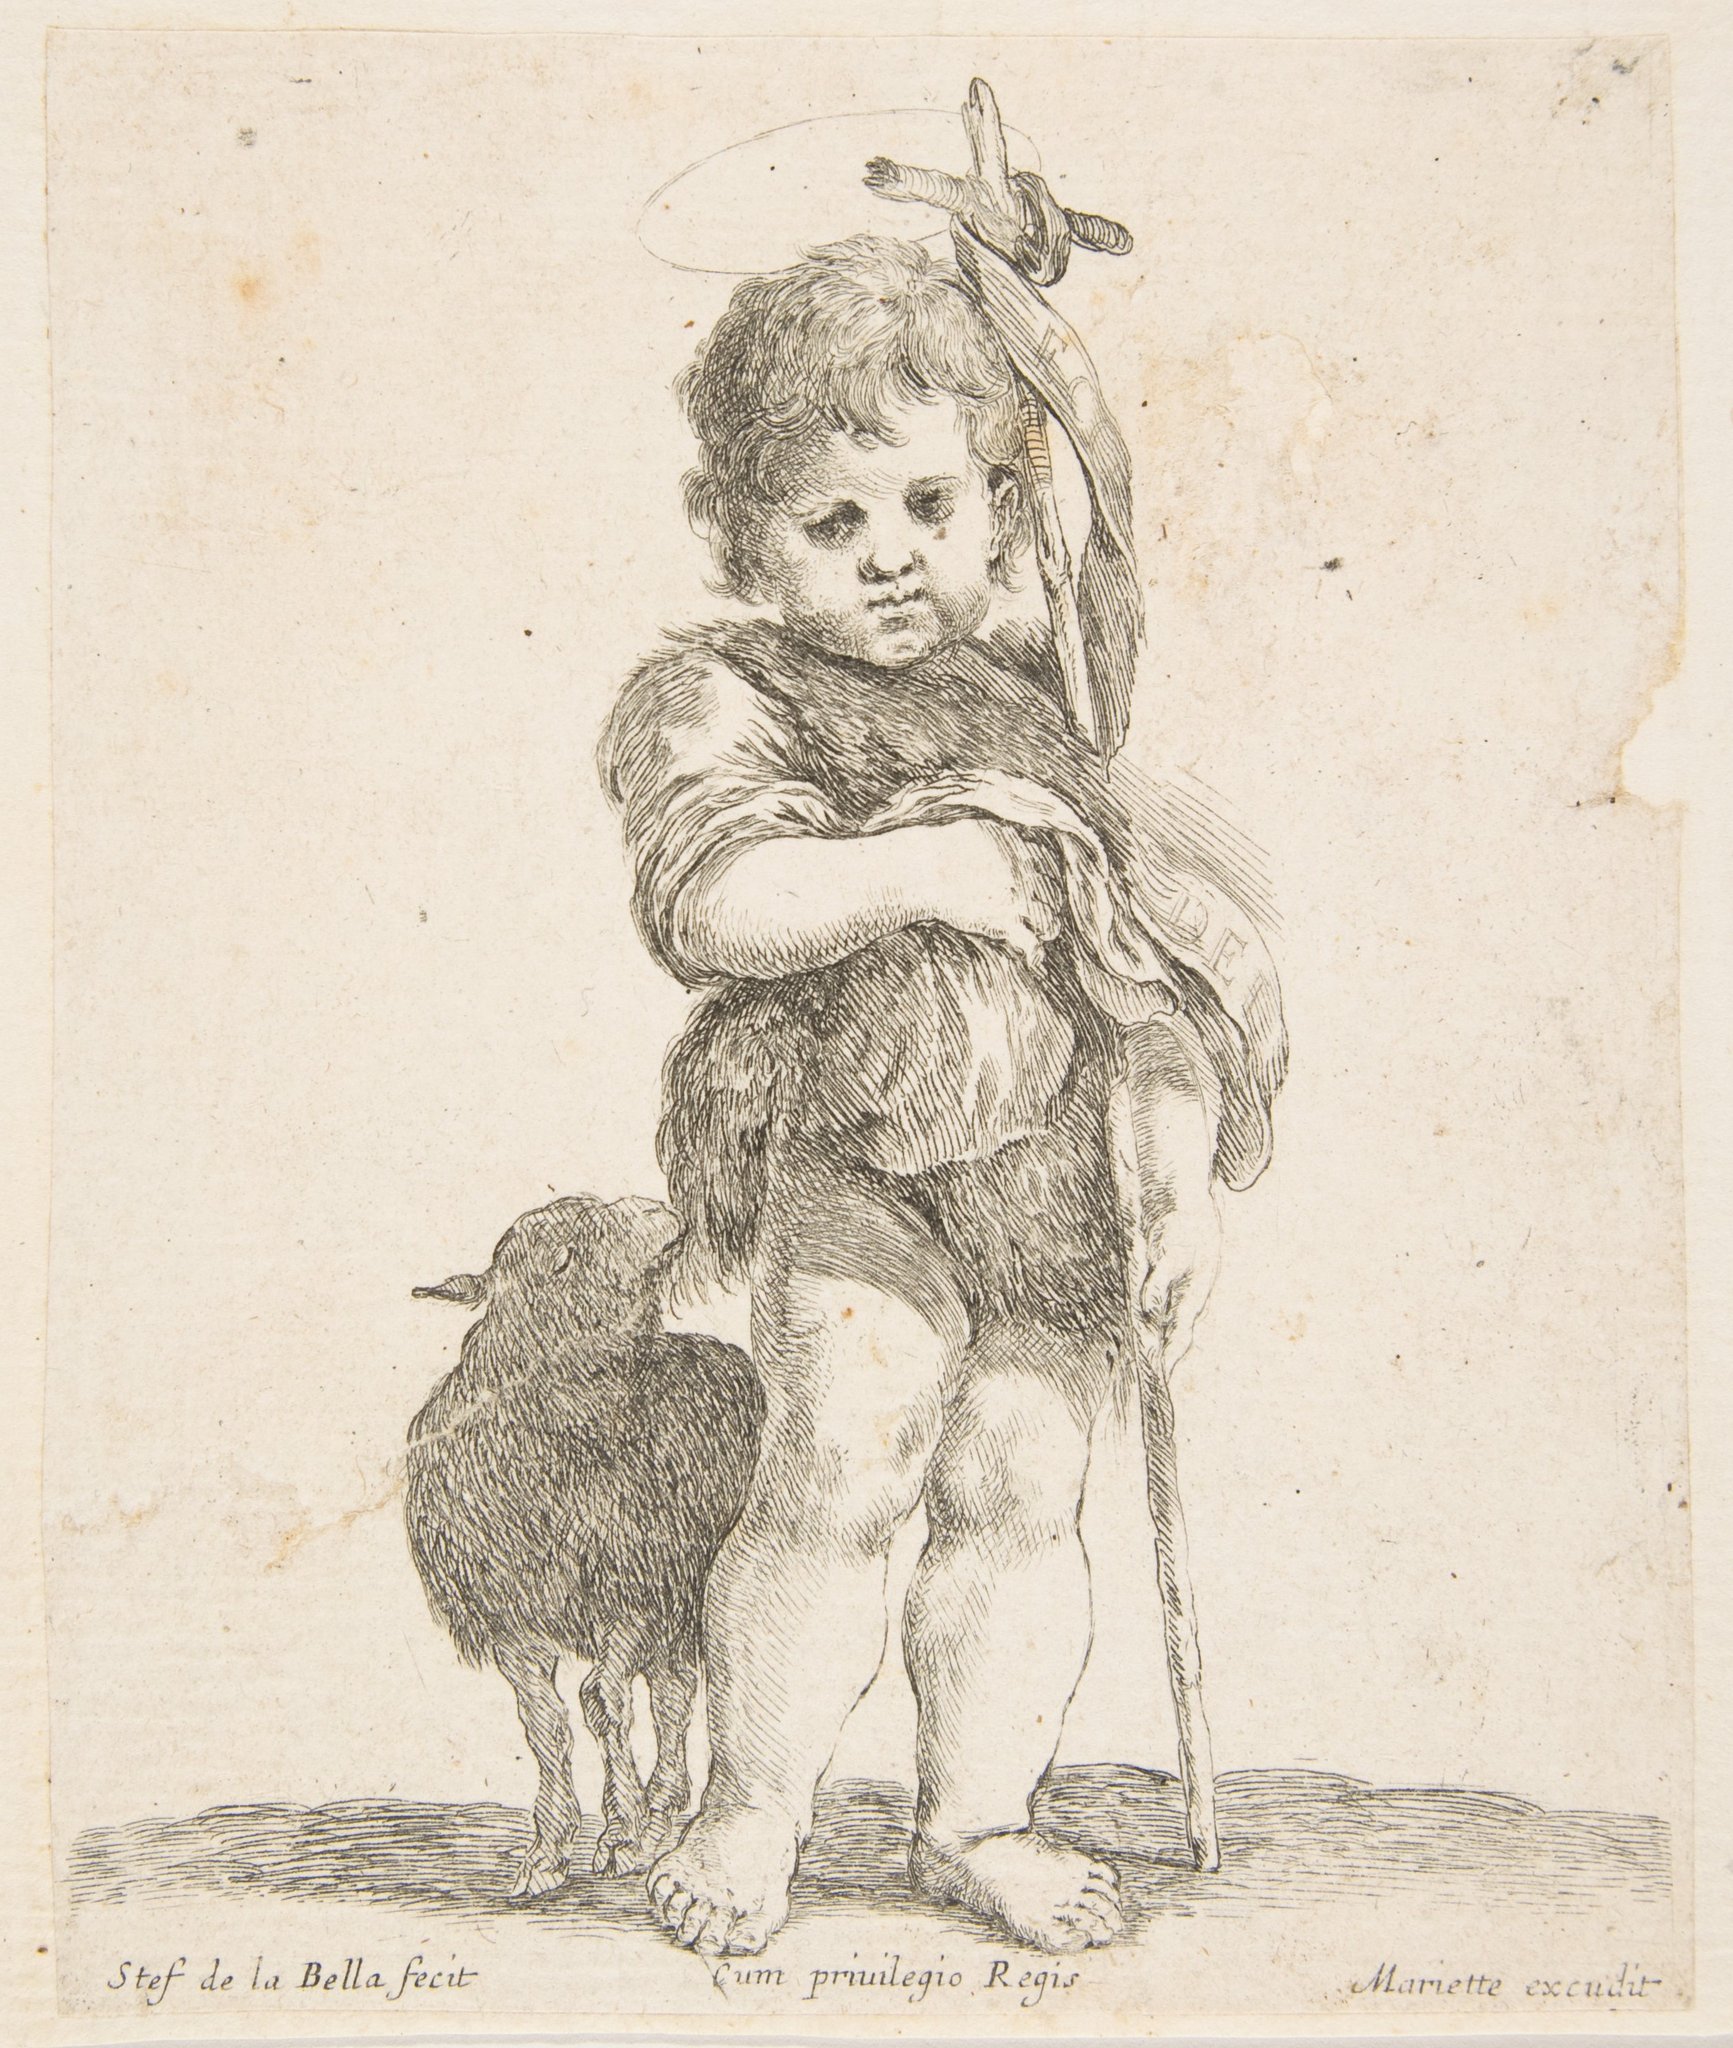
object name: print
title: Saint John the Baptist holding his folded robe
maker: stefano della bella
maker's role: artist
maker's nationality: italian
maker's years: 1610-1664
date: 1641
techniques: etching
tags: saint john the baptist